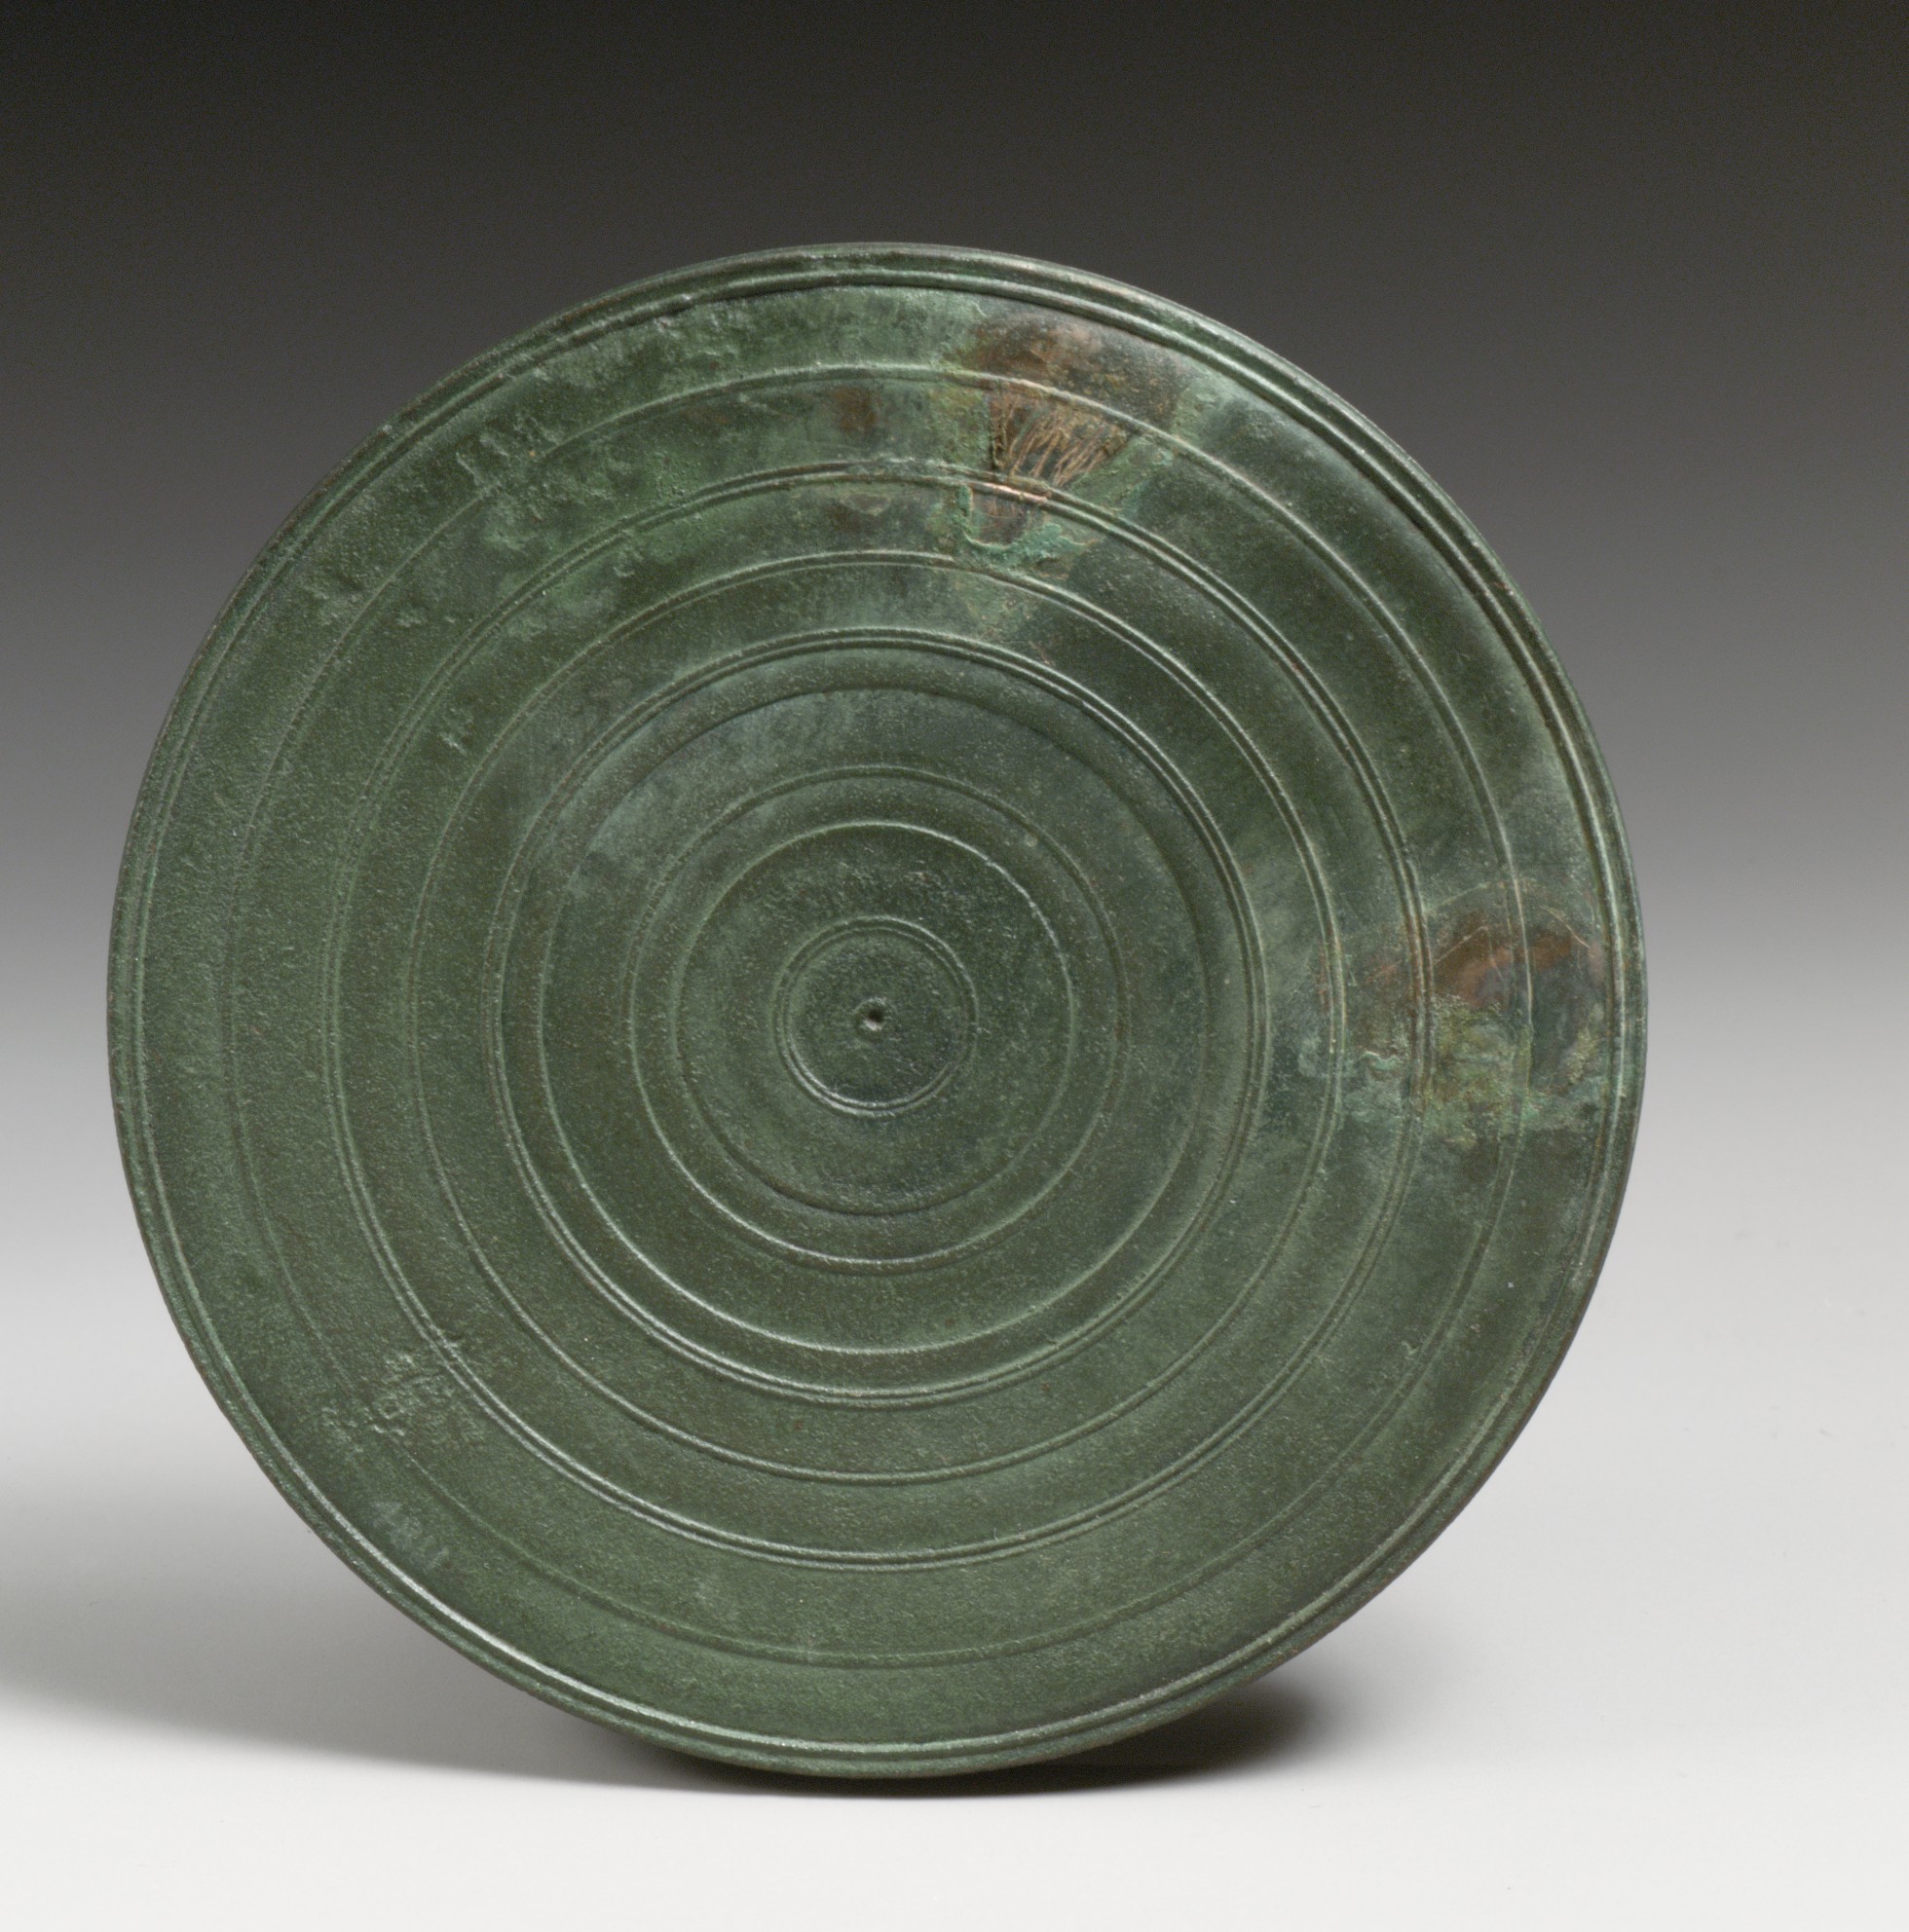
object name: mirror with cover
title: Mirror cover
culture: roman, cypriot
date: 31-330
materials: bronze